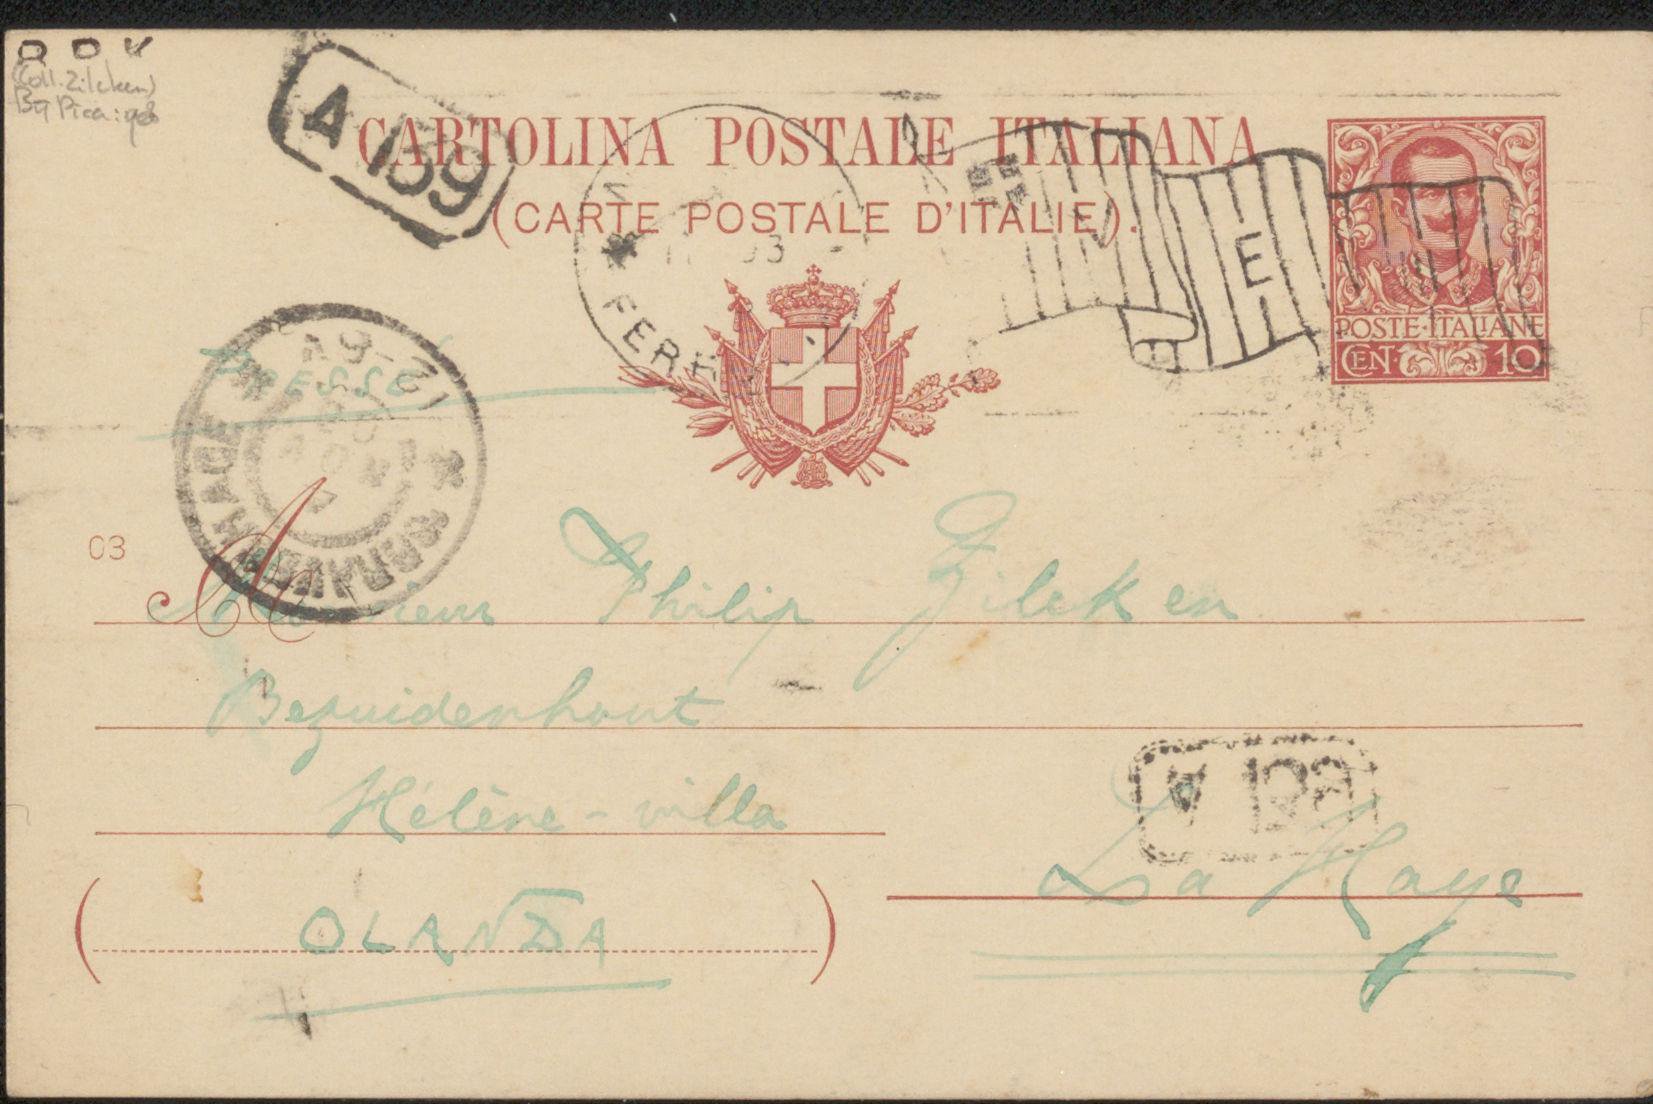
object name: postcard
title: Briefkaart aan Philip Zilcken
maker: vittorio pica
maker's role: criticus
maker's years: 1864-1930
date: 1903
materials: cardboard, ink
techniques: pen, writing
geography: naples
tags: the hague, print maker, draughtsman, carel nicolaas storm van 's-gravesande, painter, jan toorop, albrecht felix reicher, philip zilcken, the graphic arts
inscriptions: collector's mark: ‘RPK’